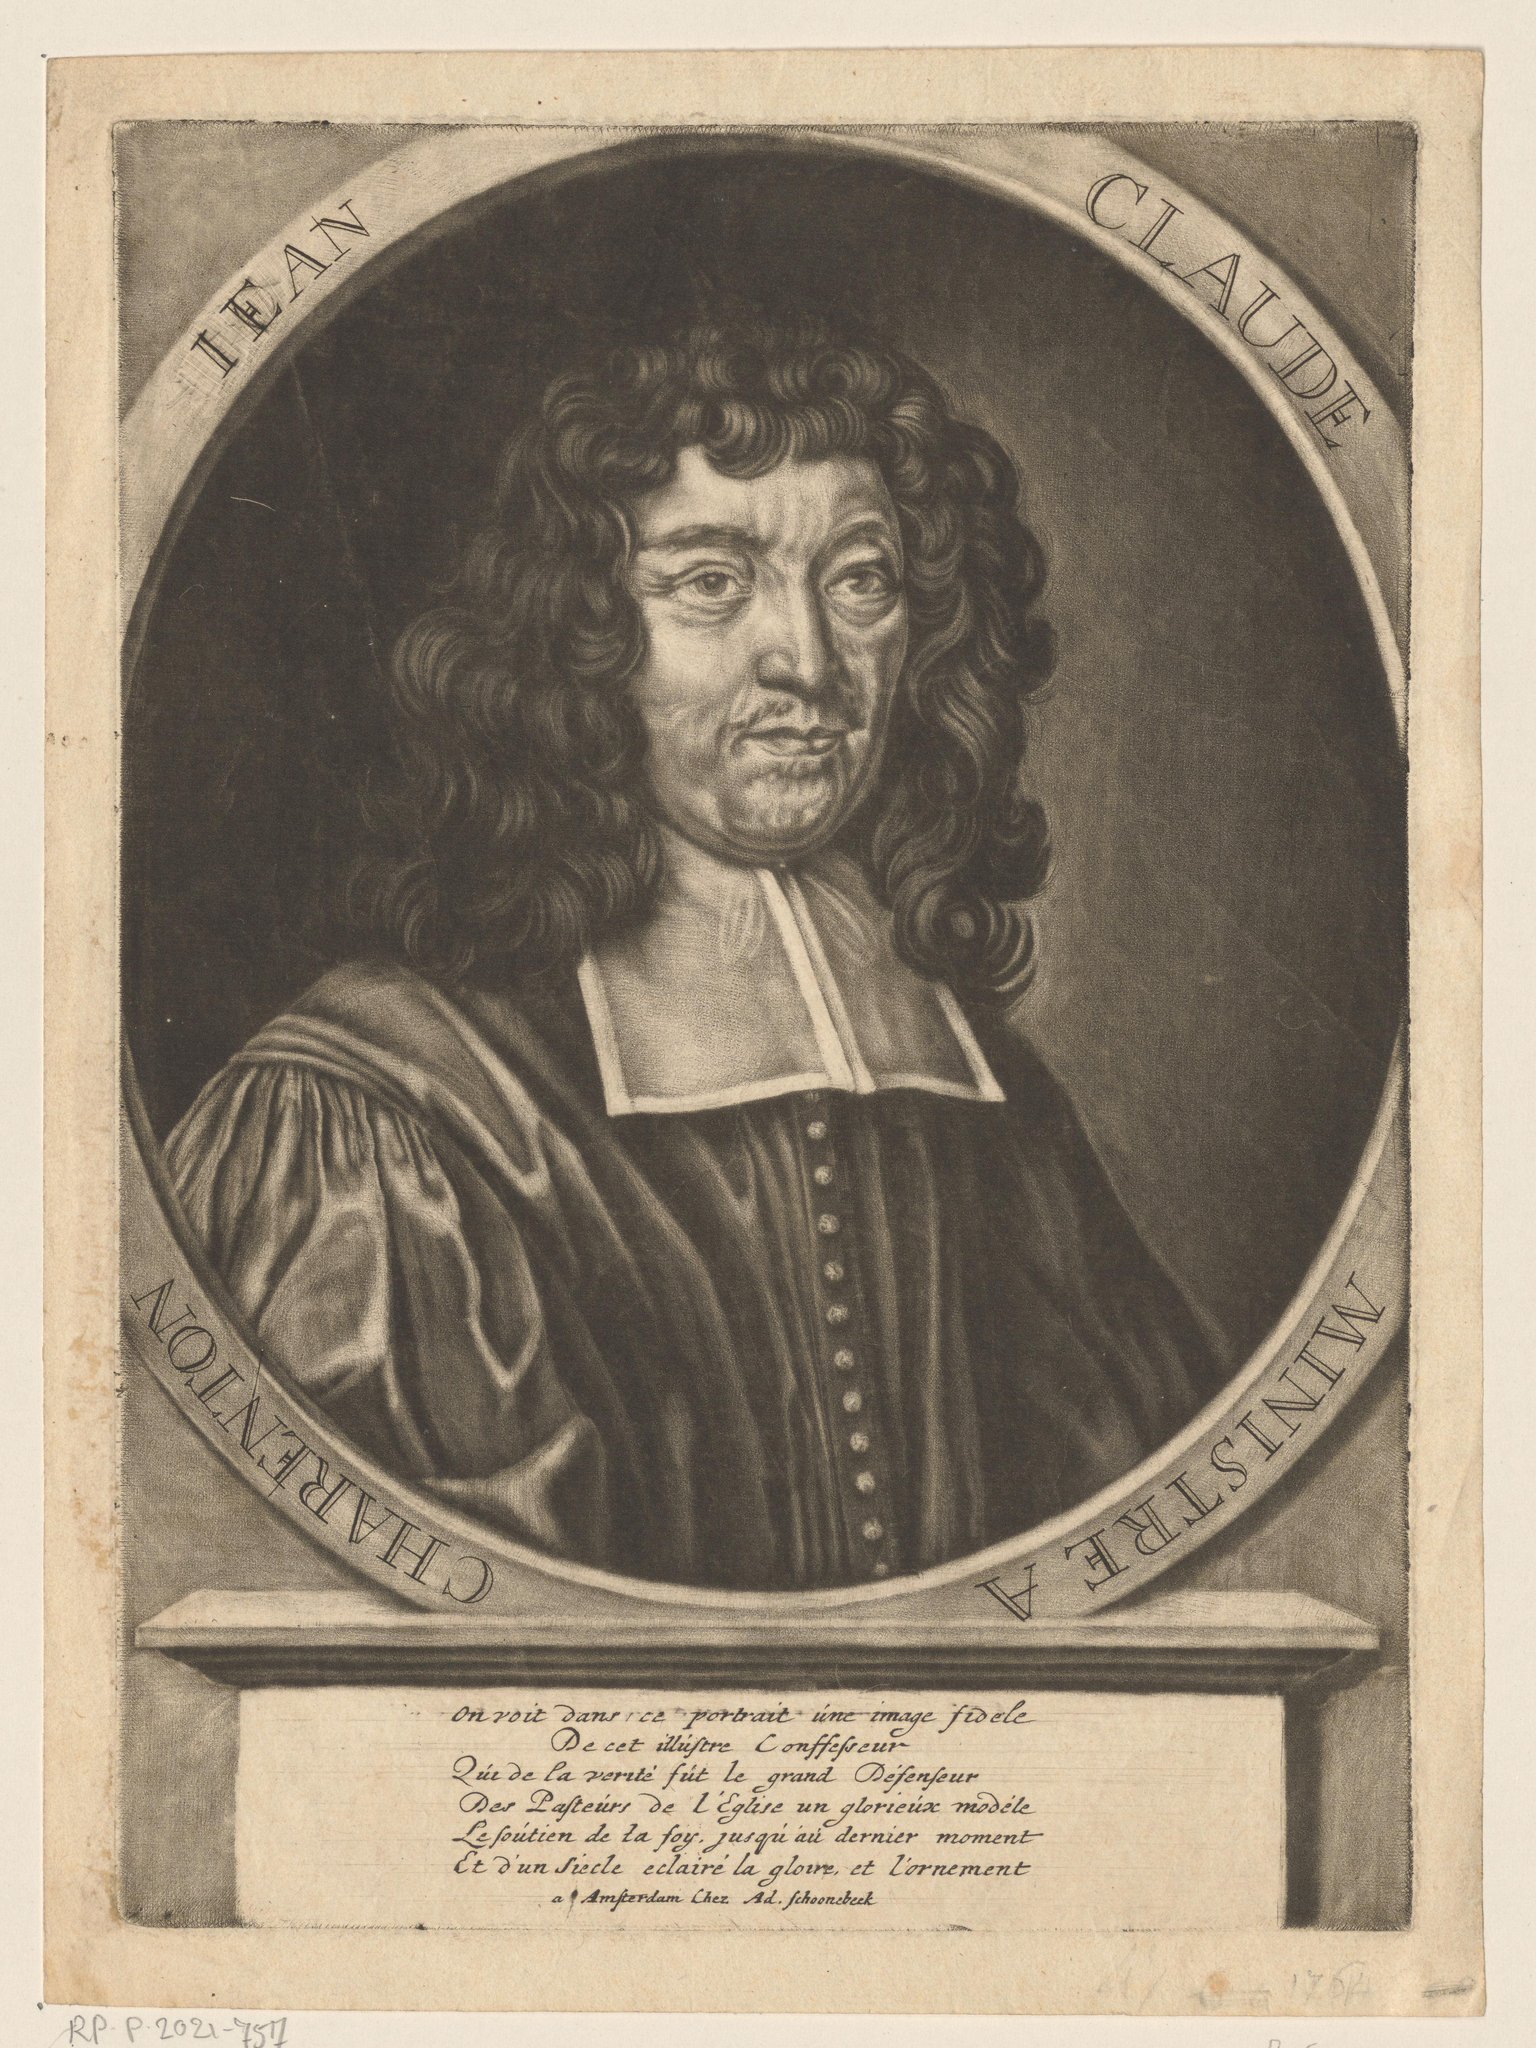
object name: print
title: Portret van Jean Claude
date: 1688-1705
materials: paper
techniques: engraving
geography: amsterdam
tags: the hague, historical persons